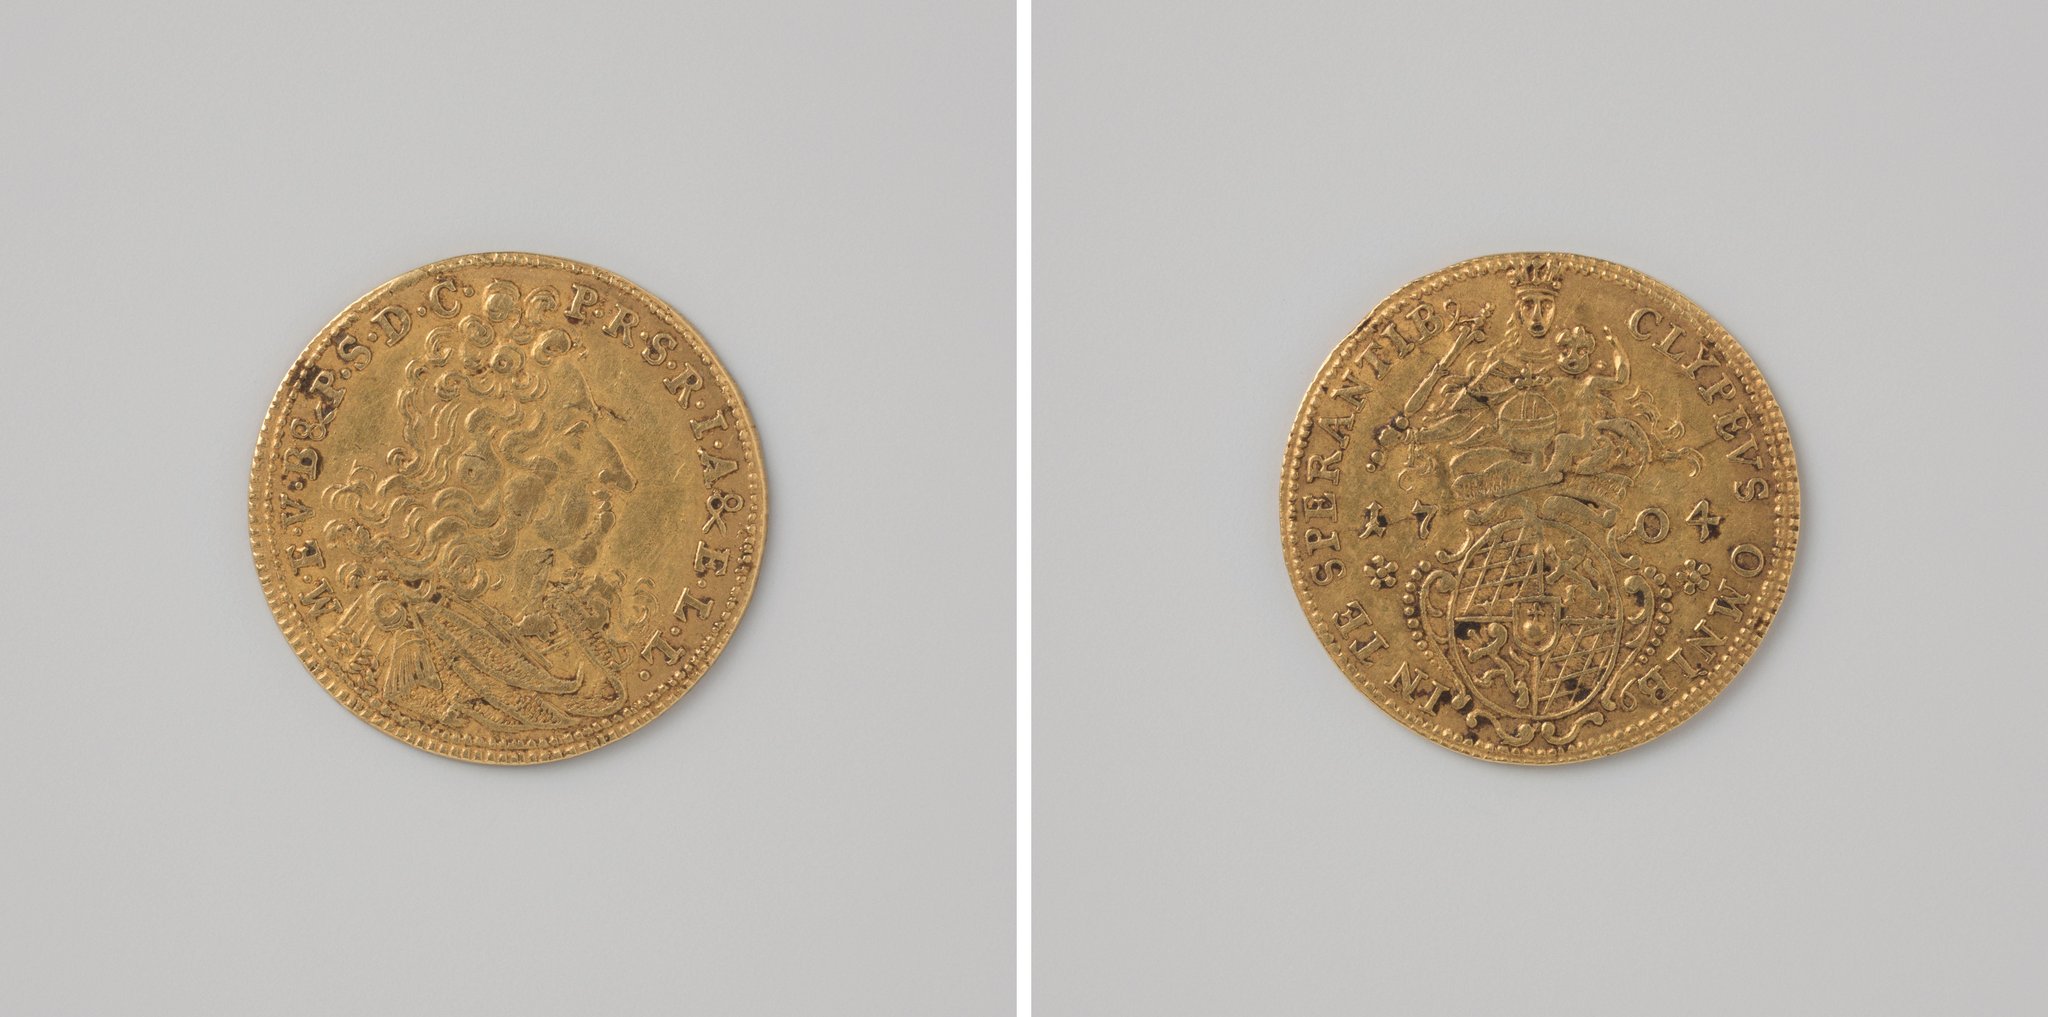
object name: coin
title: Goudgulden uit het hertogdom Beieren van keurvorst Maximilian Emanuel, 1704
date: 1704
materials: gold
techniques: striking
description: Gouden munt. Voorzijde: borstbeeld van de keurvorst naar rechts, waaronder pijnappel [=bezetting van Augsburg]. Keerzijde: tussen jaartal gekroonde Madonna met kind en zwaard en rijksappel, waaronder versierd wapenschild. Gladde rand.